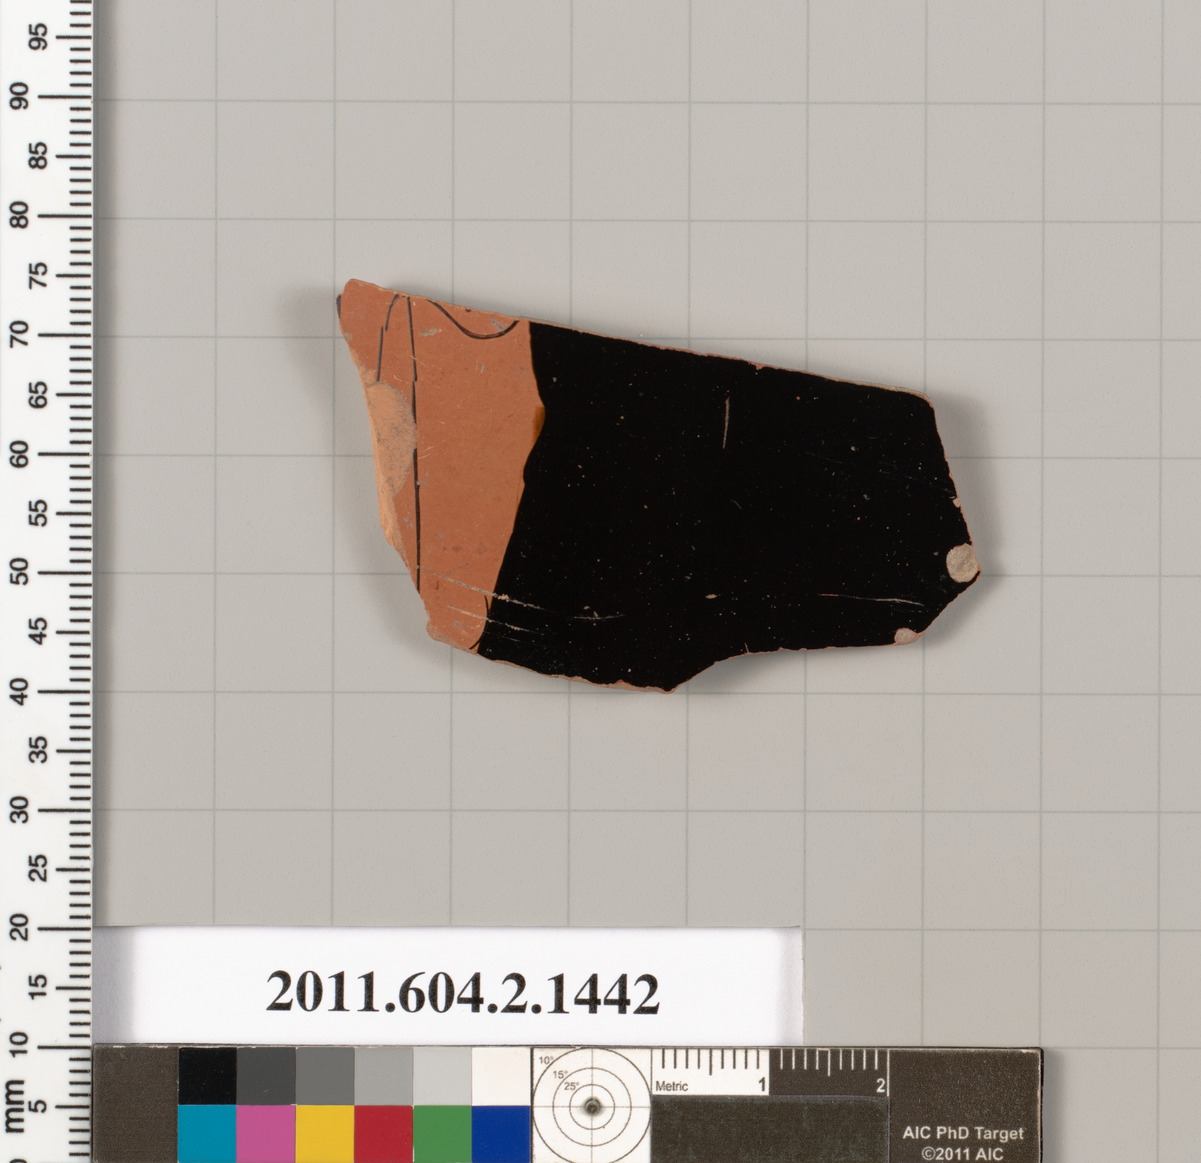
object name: skyphos fragment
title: Terracotta fragment of a skyphos (deep drinking cup)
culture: greek, attic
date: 475-451 BCE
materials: terracotta